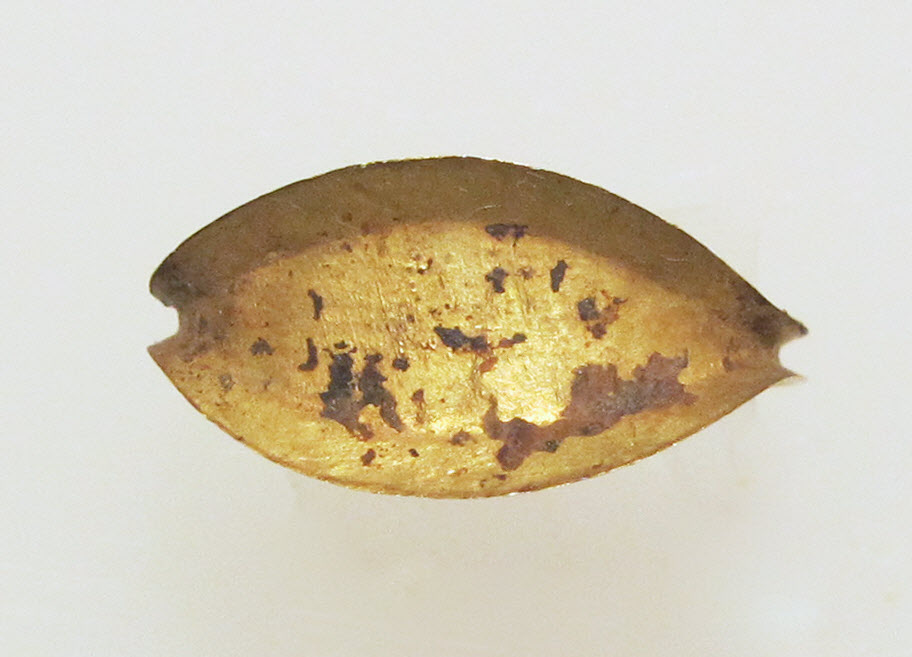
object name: ring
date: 7000 BCE-330 CE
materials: gold